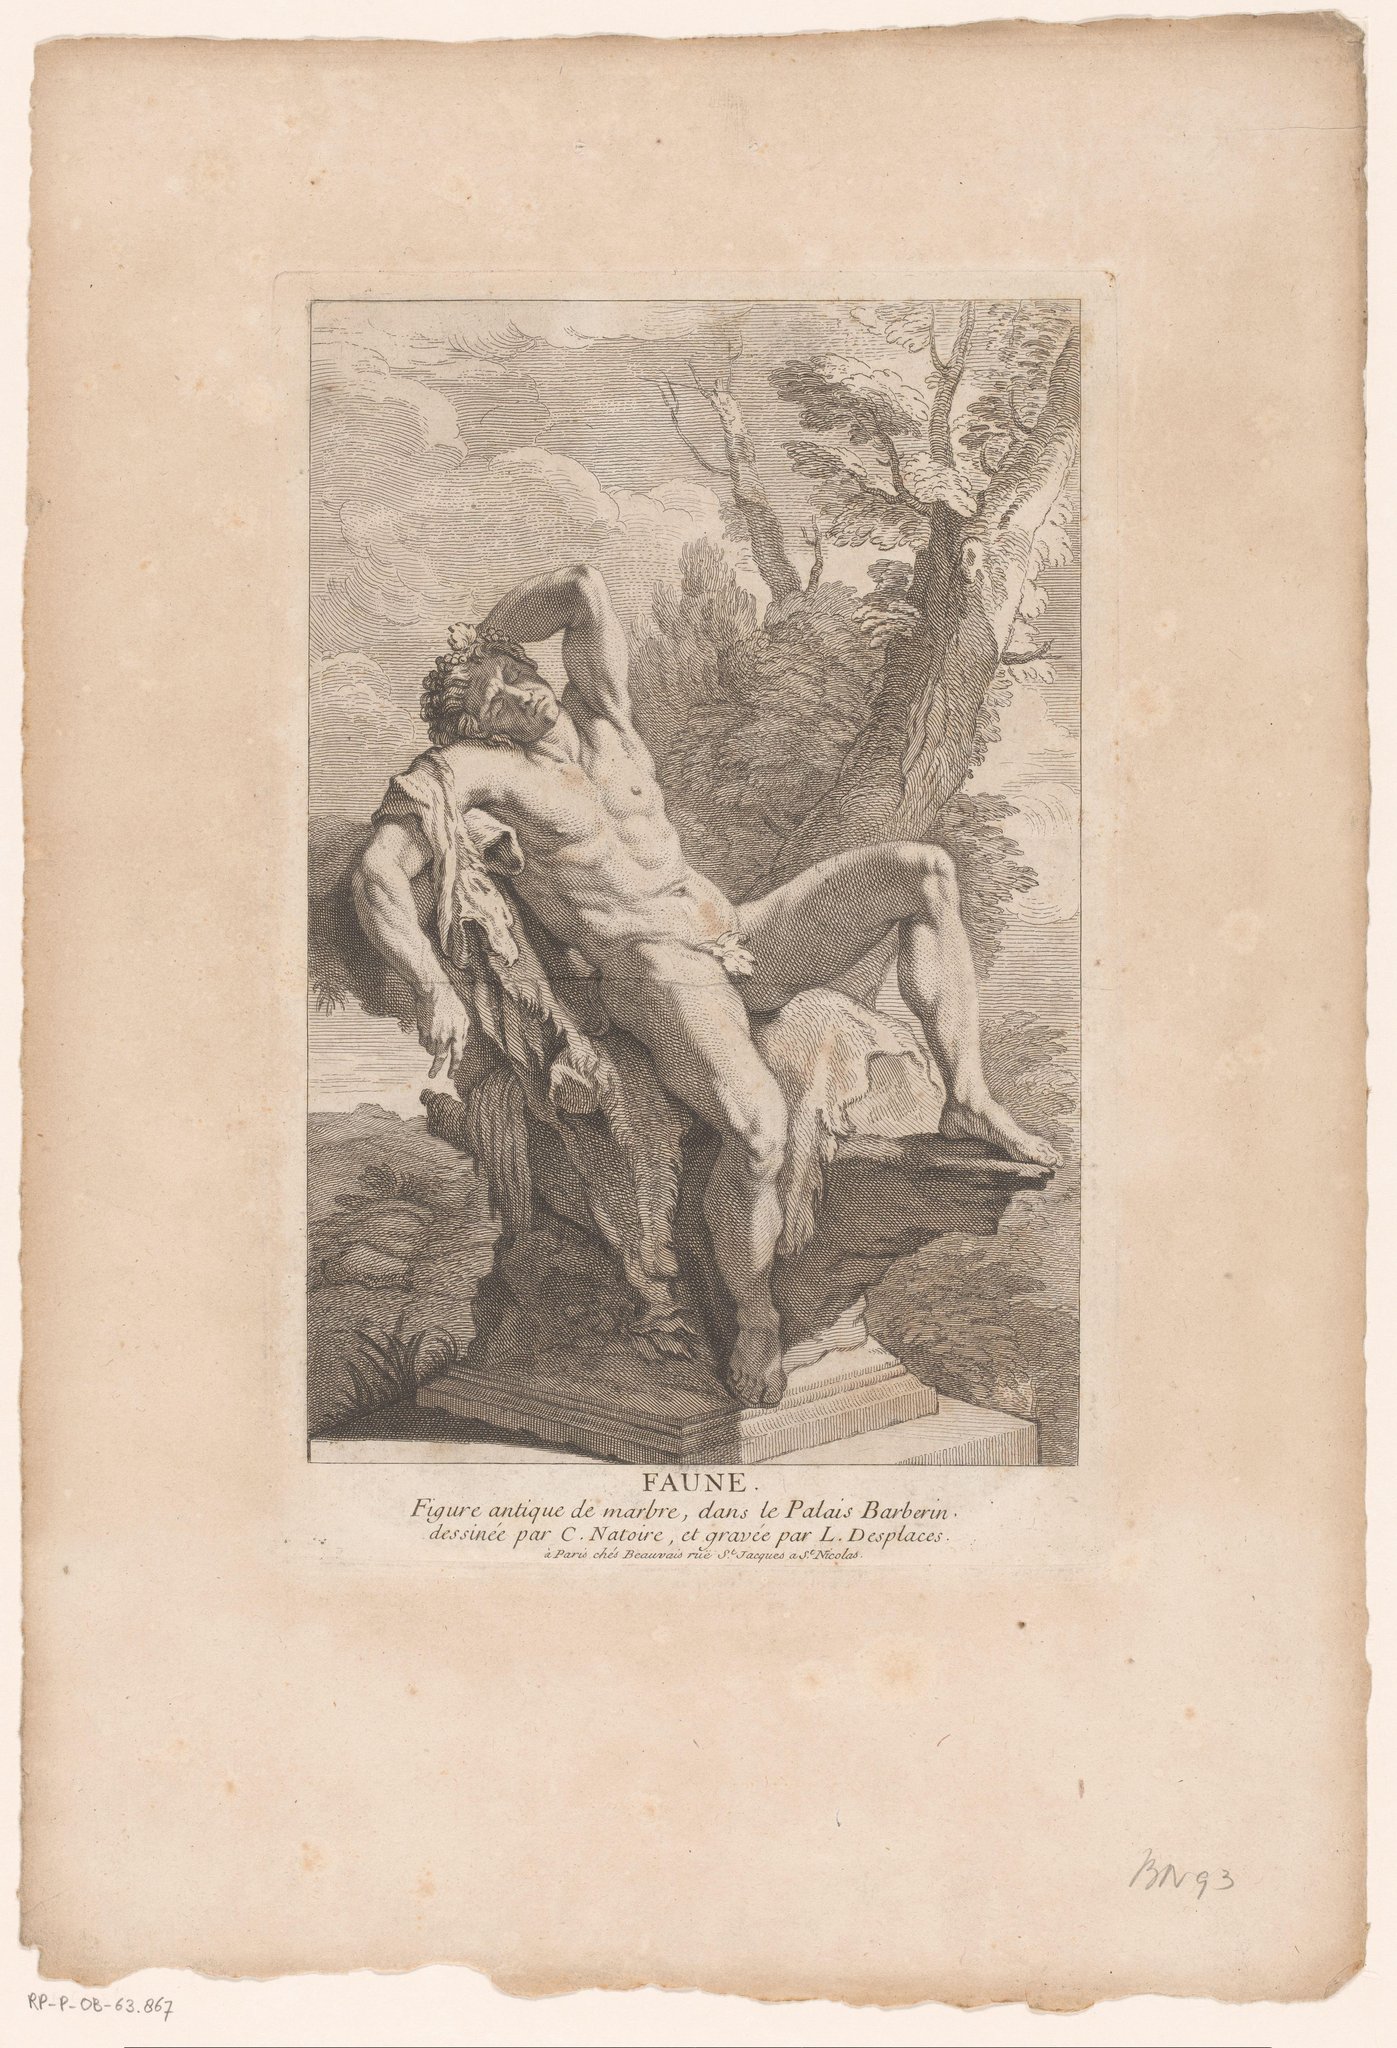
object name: print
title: Beeld van een slapende faun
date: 1697-1739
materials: paper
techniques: engraving, etching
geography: paris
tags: satyrs, fauns, sileni, piece of sculpture, reproduction of a piece of sculpture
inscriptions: collector's mark: Lugt 2228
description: Het beeld van deze slapende faun, ook wel de Barberini Faun genoemd van een onbekende Hellenistische beeldhouwer, bevindt zich de Glyptothek te München.